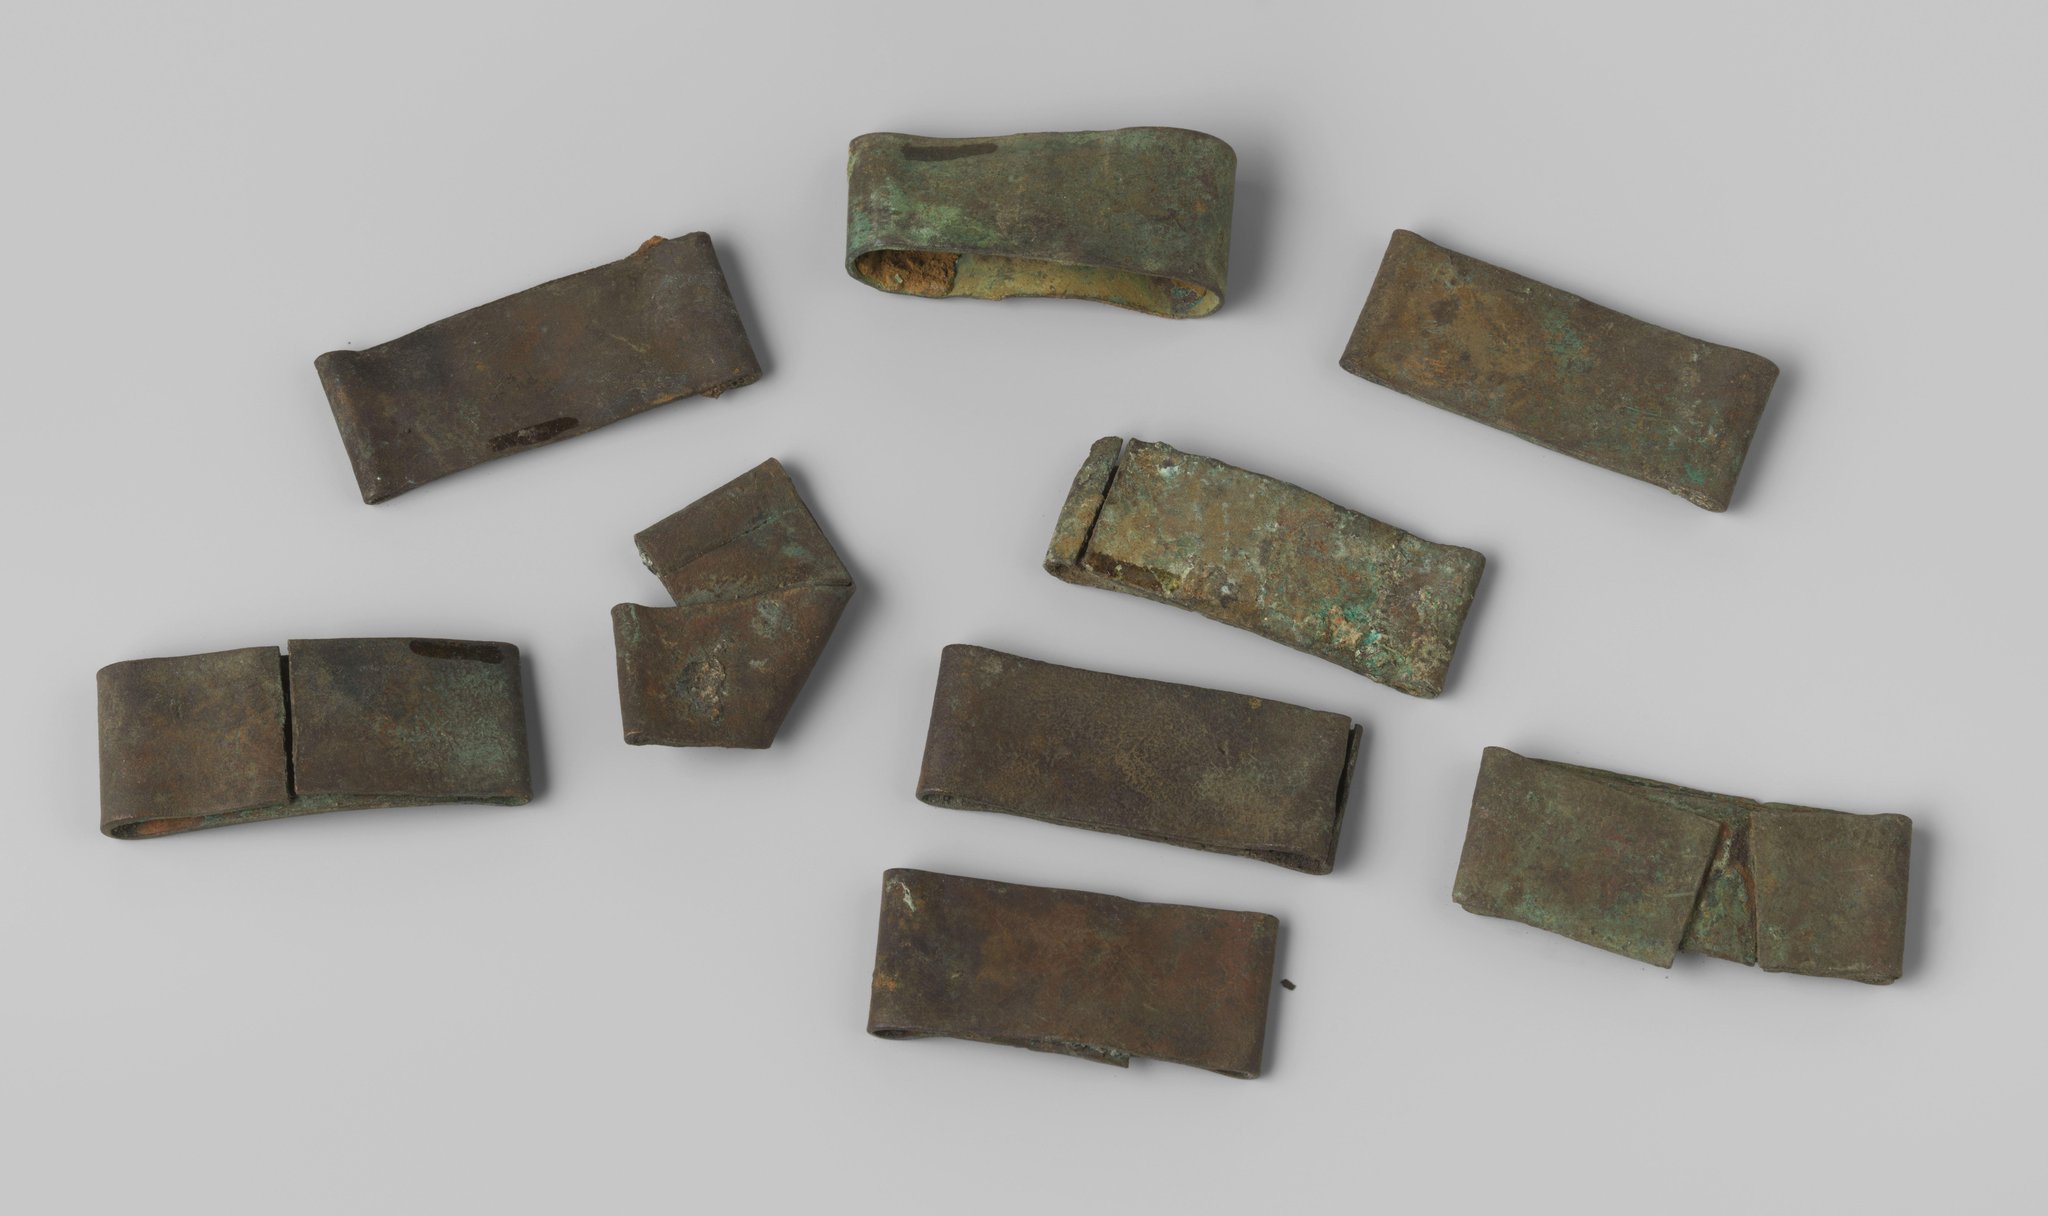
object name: firehose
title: Brandslangringen uit het wrak van de Oost-Indiëvaarder Hollandia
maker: Anonymous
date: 1700-1743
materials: copper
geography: netherlands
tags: verenigde oostindische compagnie, hollandia (schip), annet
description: Fire engine, firehose; fragm, id. NG 1975-20H1271a, squashed.